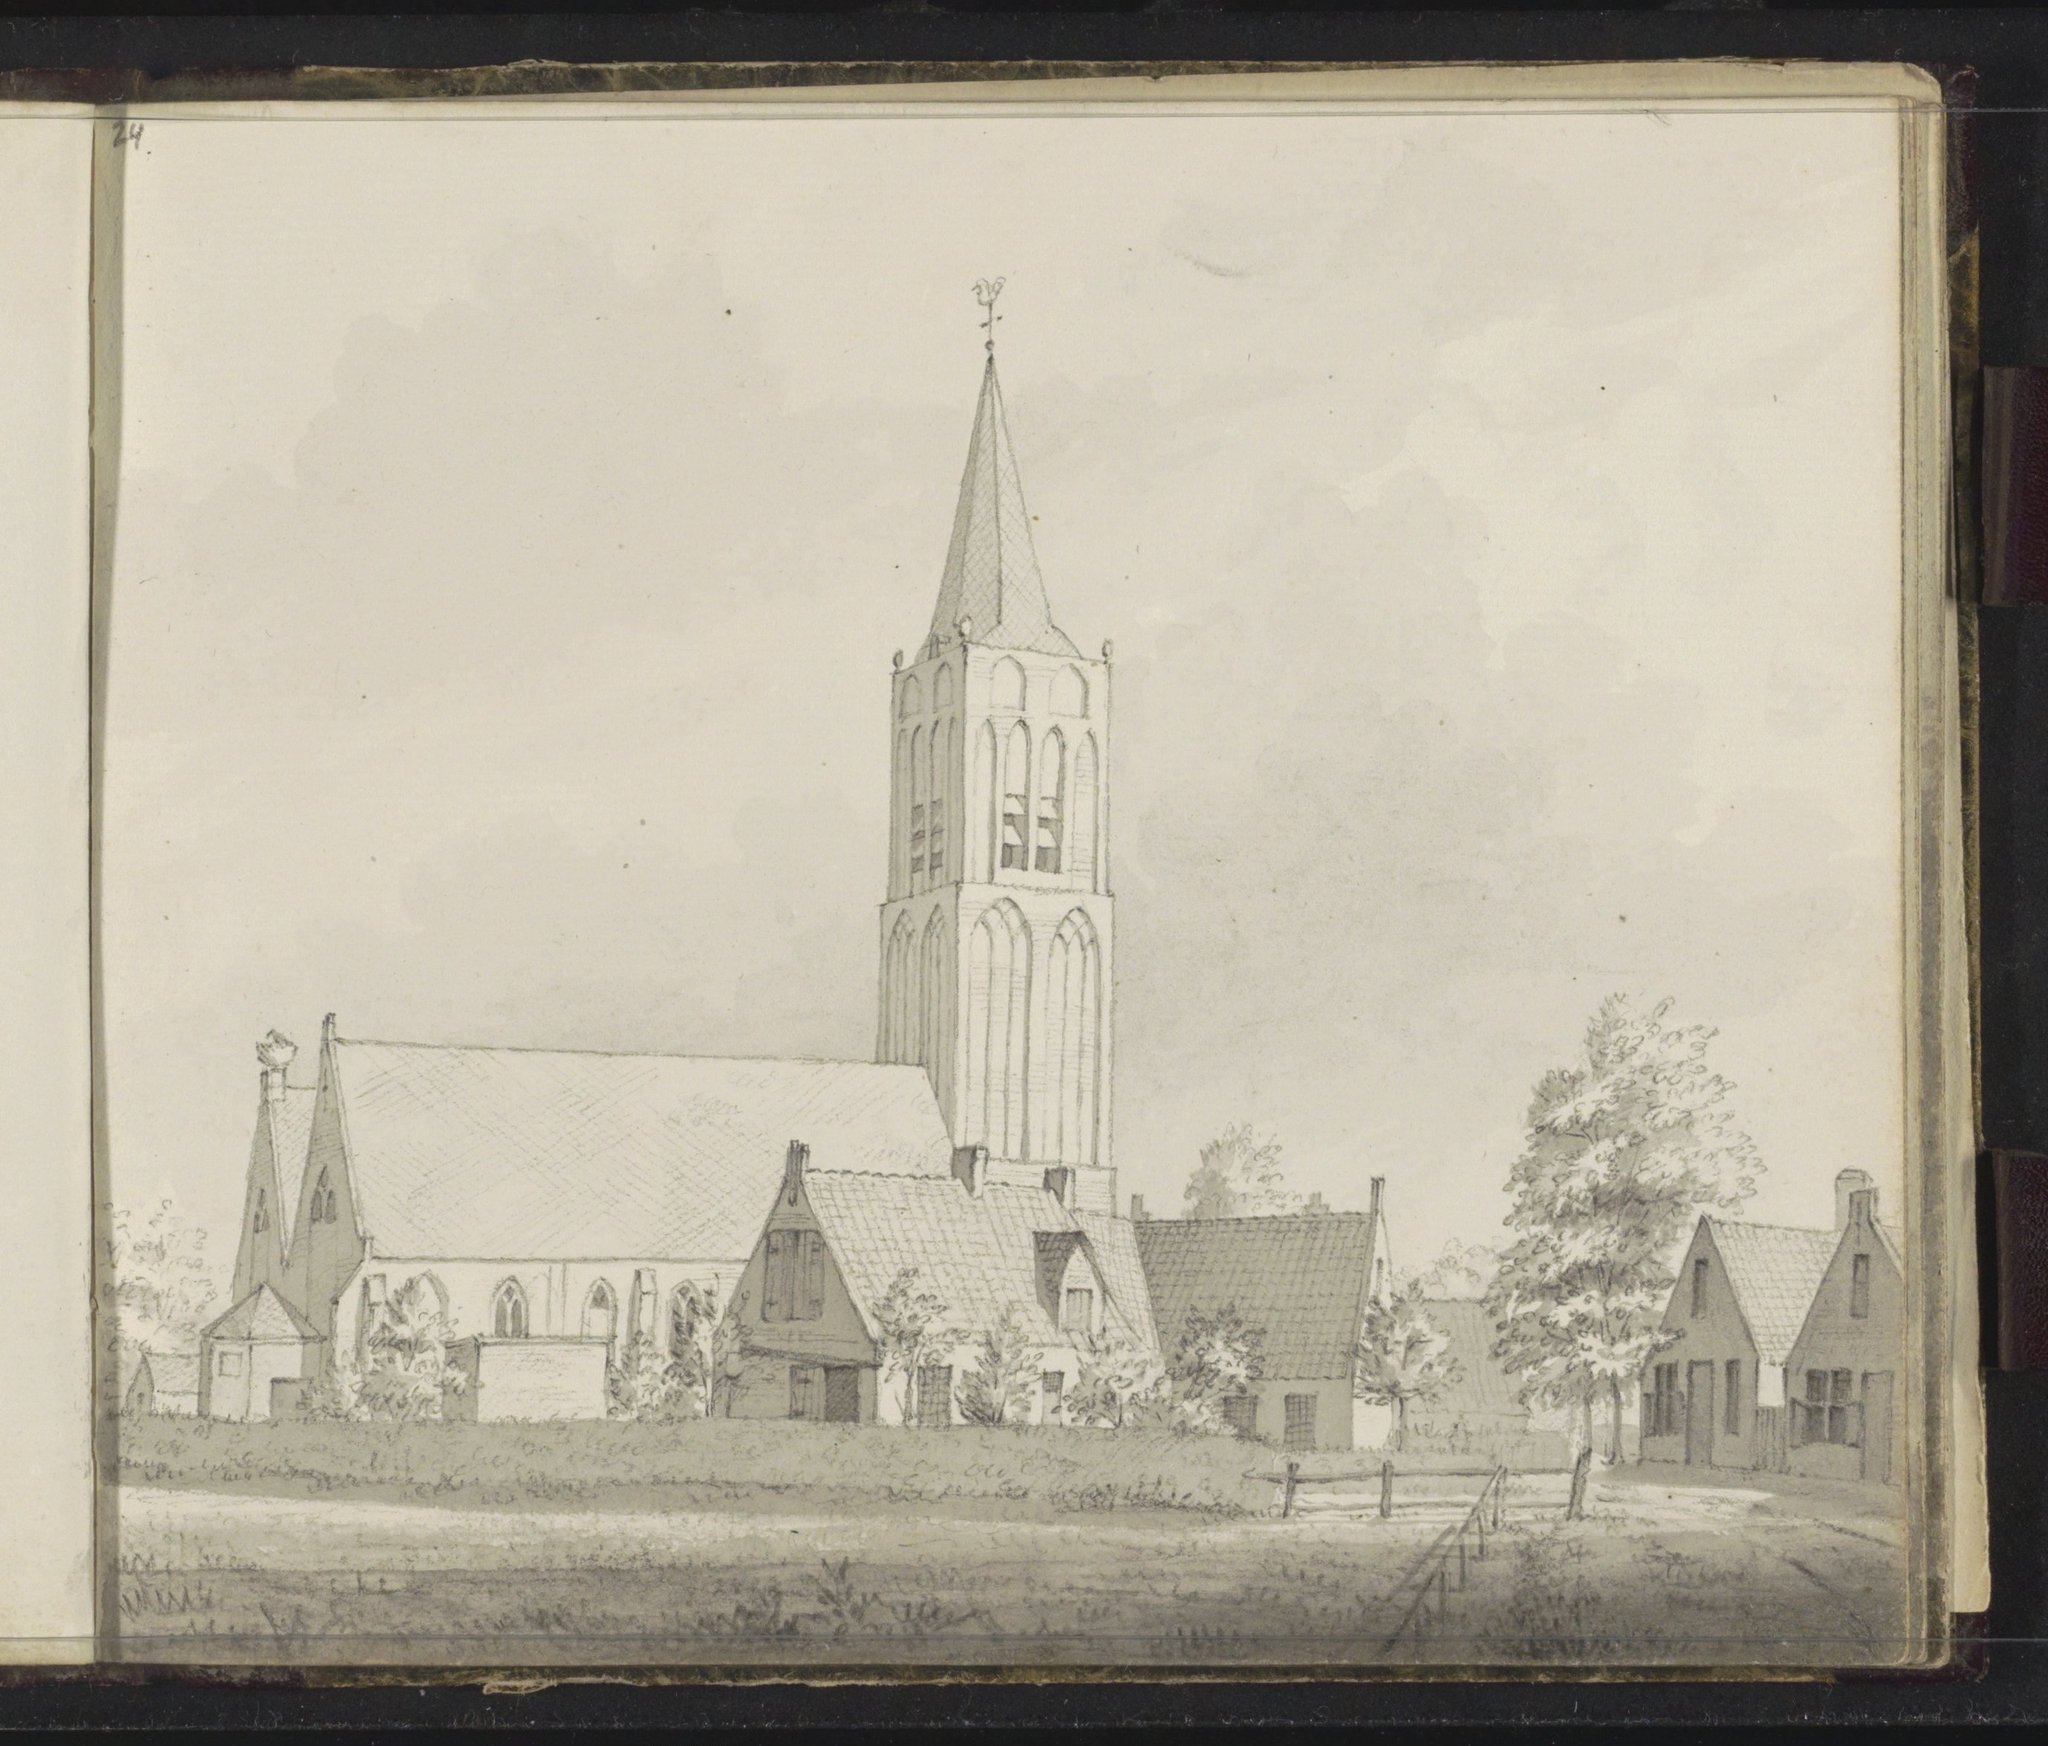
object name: sketchbook leaf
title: Grote Kerk te Beverwijk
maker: hendrik abraham klinkhamer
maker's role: draughtsman, painter, print maker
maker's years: 1810-1872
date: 1820-1872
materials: chalk, paper, watercolor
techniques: brush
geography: beverwijk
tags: church (exterior)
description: Blad 24 recto uit een schetsboek met 39 bladen.